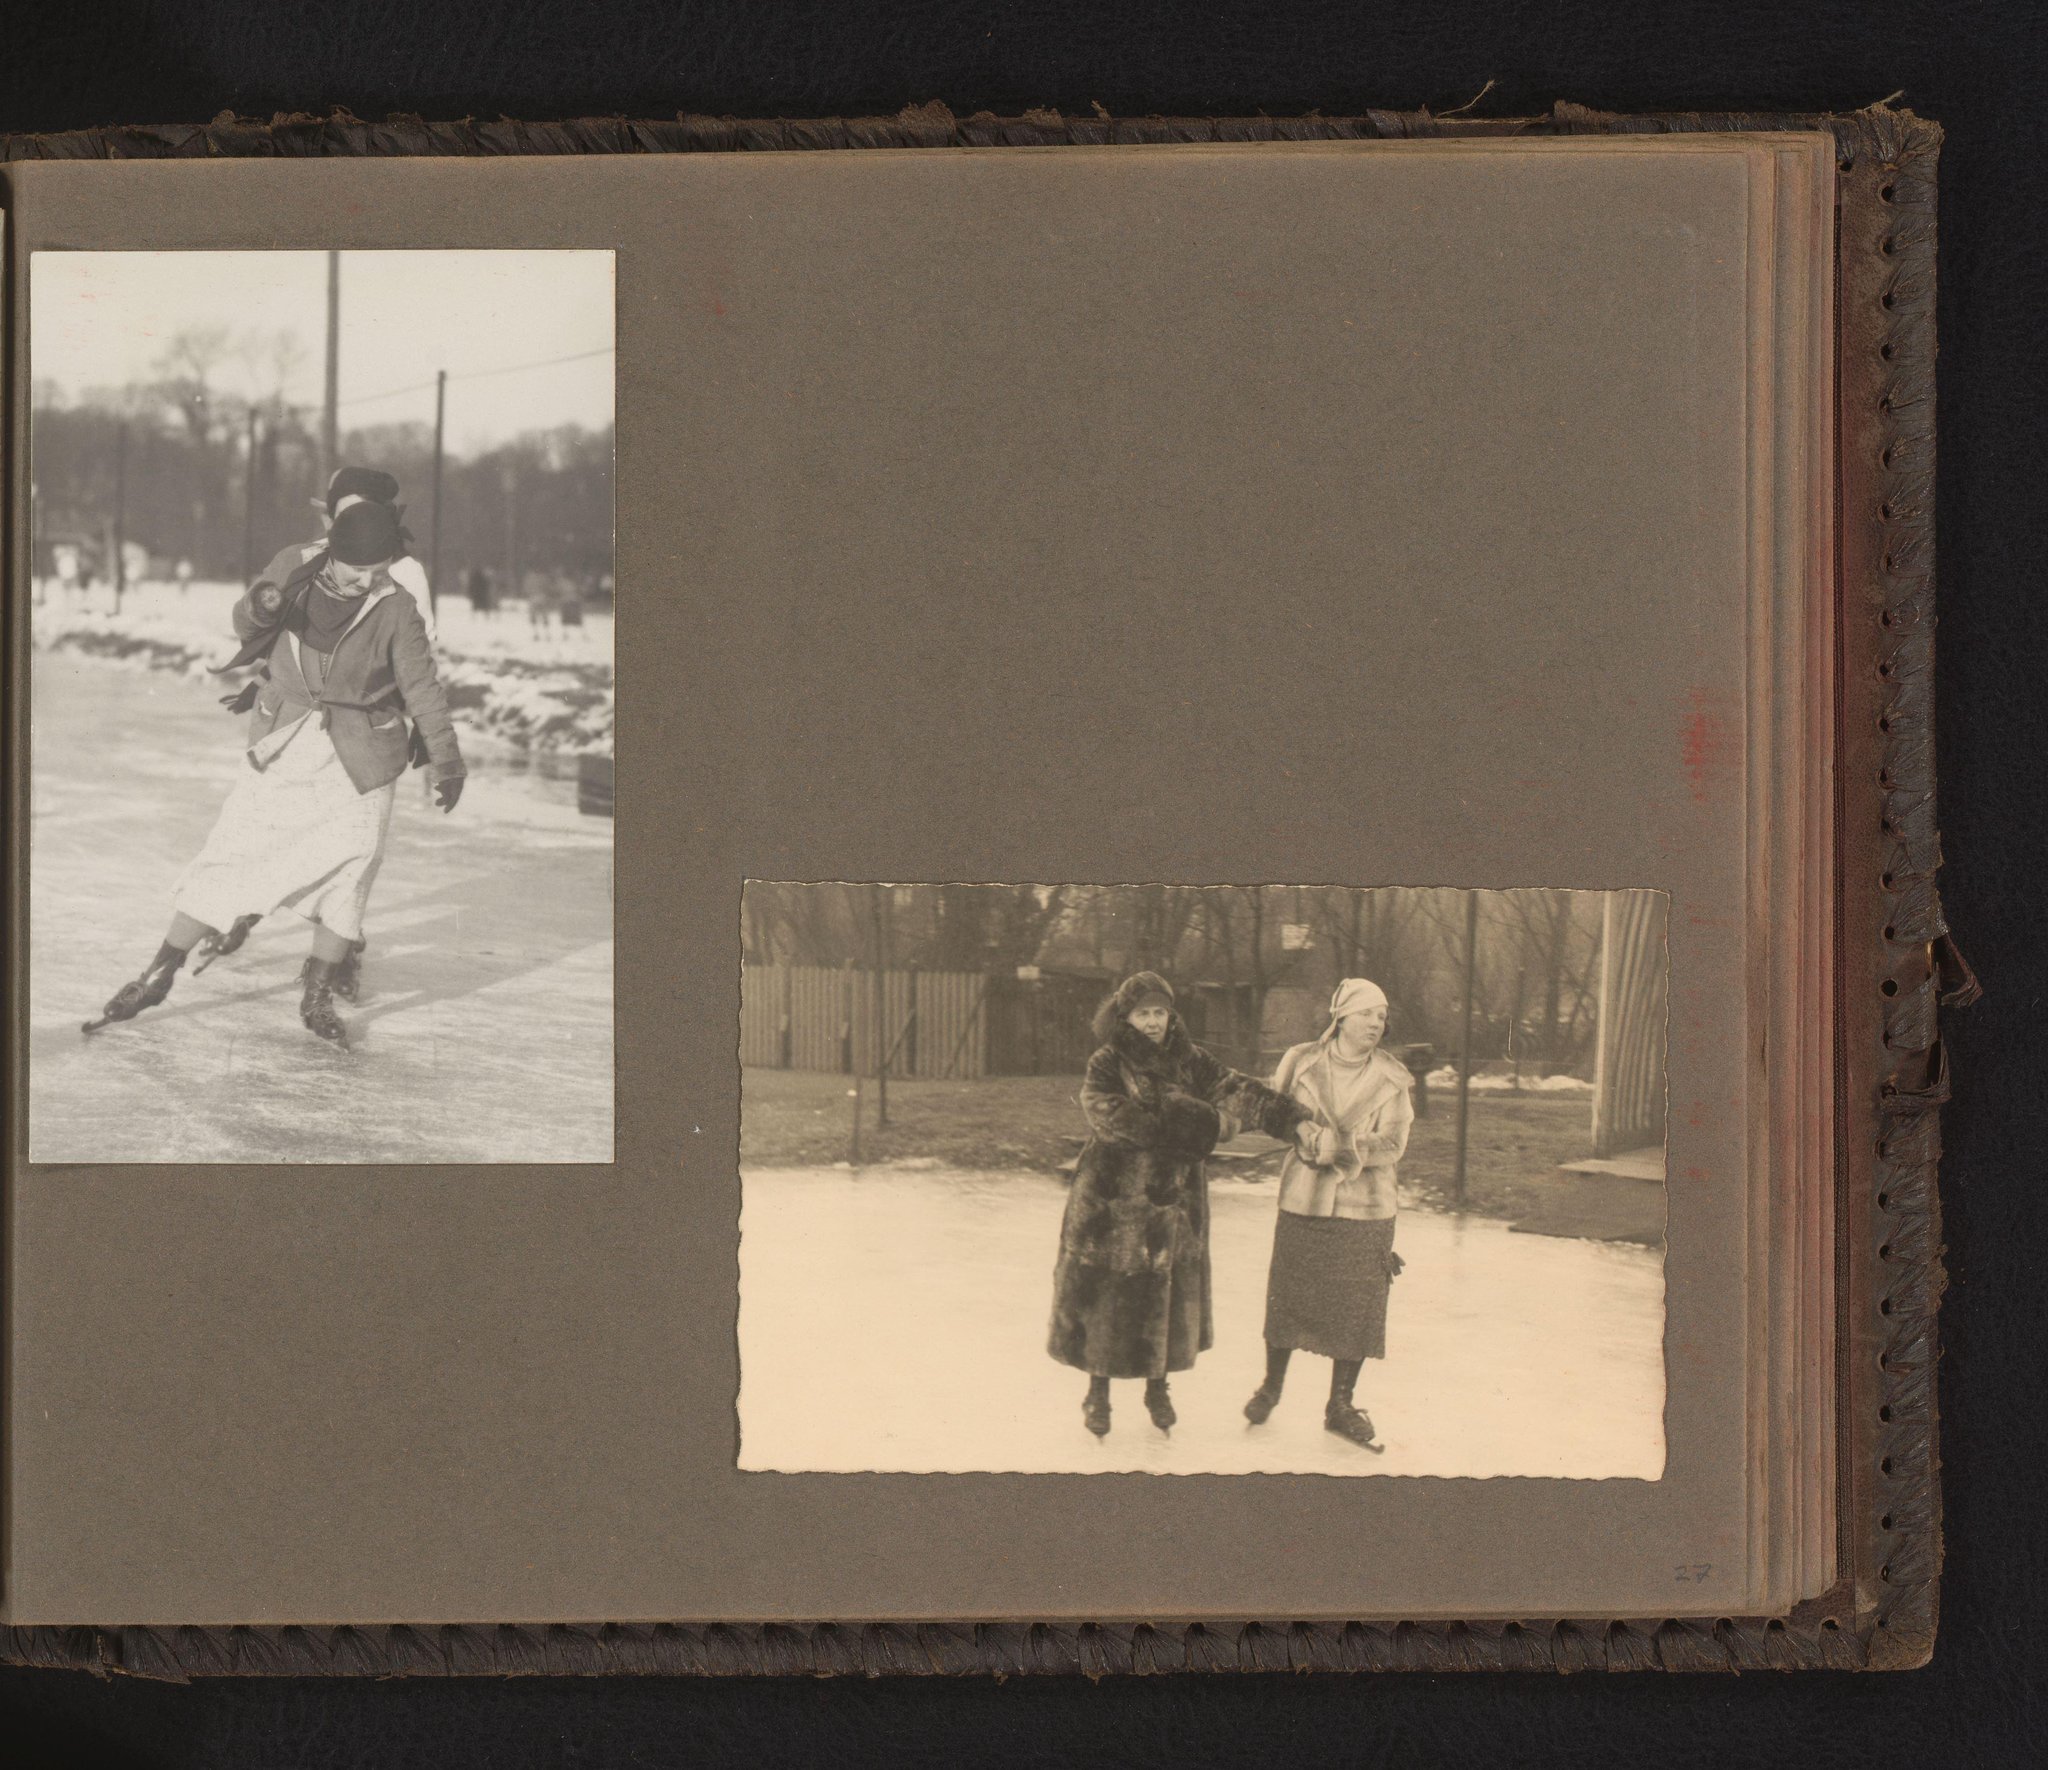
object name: album leaf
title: Twee foto's van prinses Juliana schaatsend, met koningin Wilhelmina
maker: Anonymous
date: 1933-1938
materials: paper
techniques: gelatin silver print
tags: print maker, wilhelmina of the netherlands, the hague, juliana of the netherlands, skates (winter sports)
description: Deze foto's maken deel uit van een album.